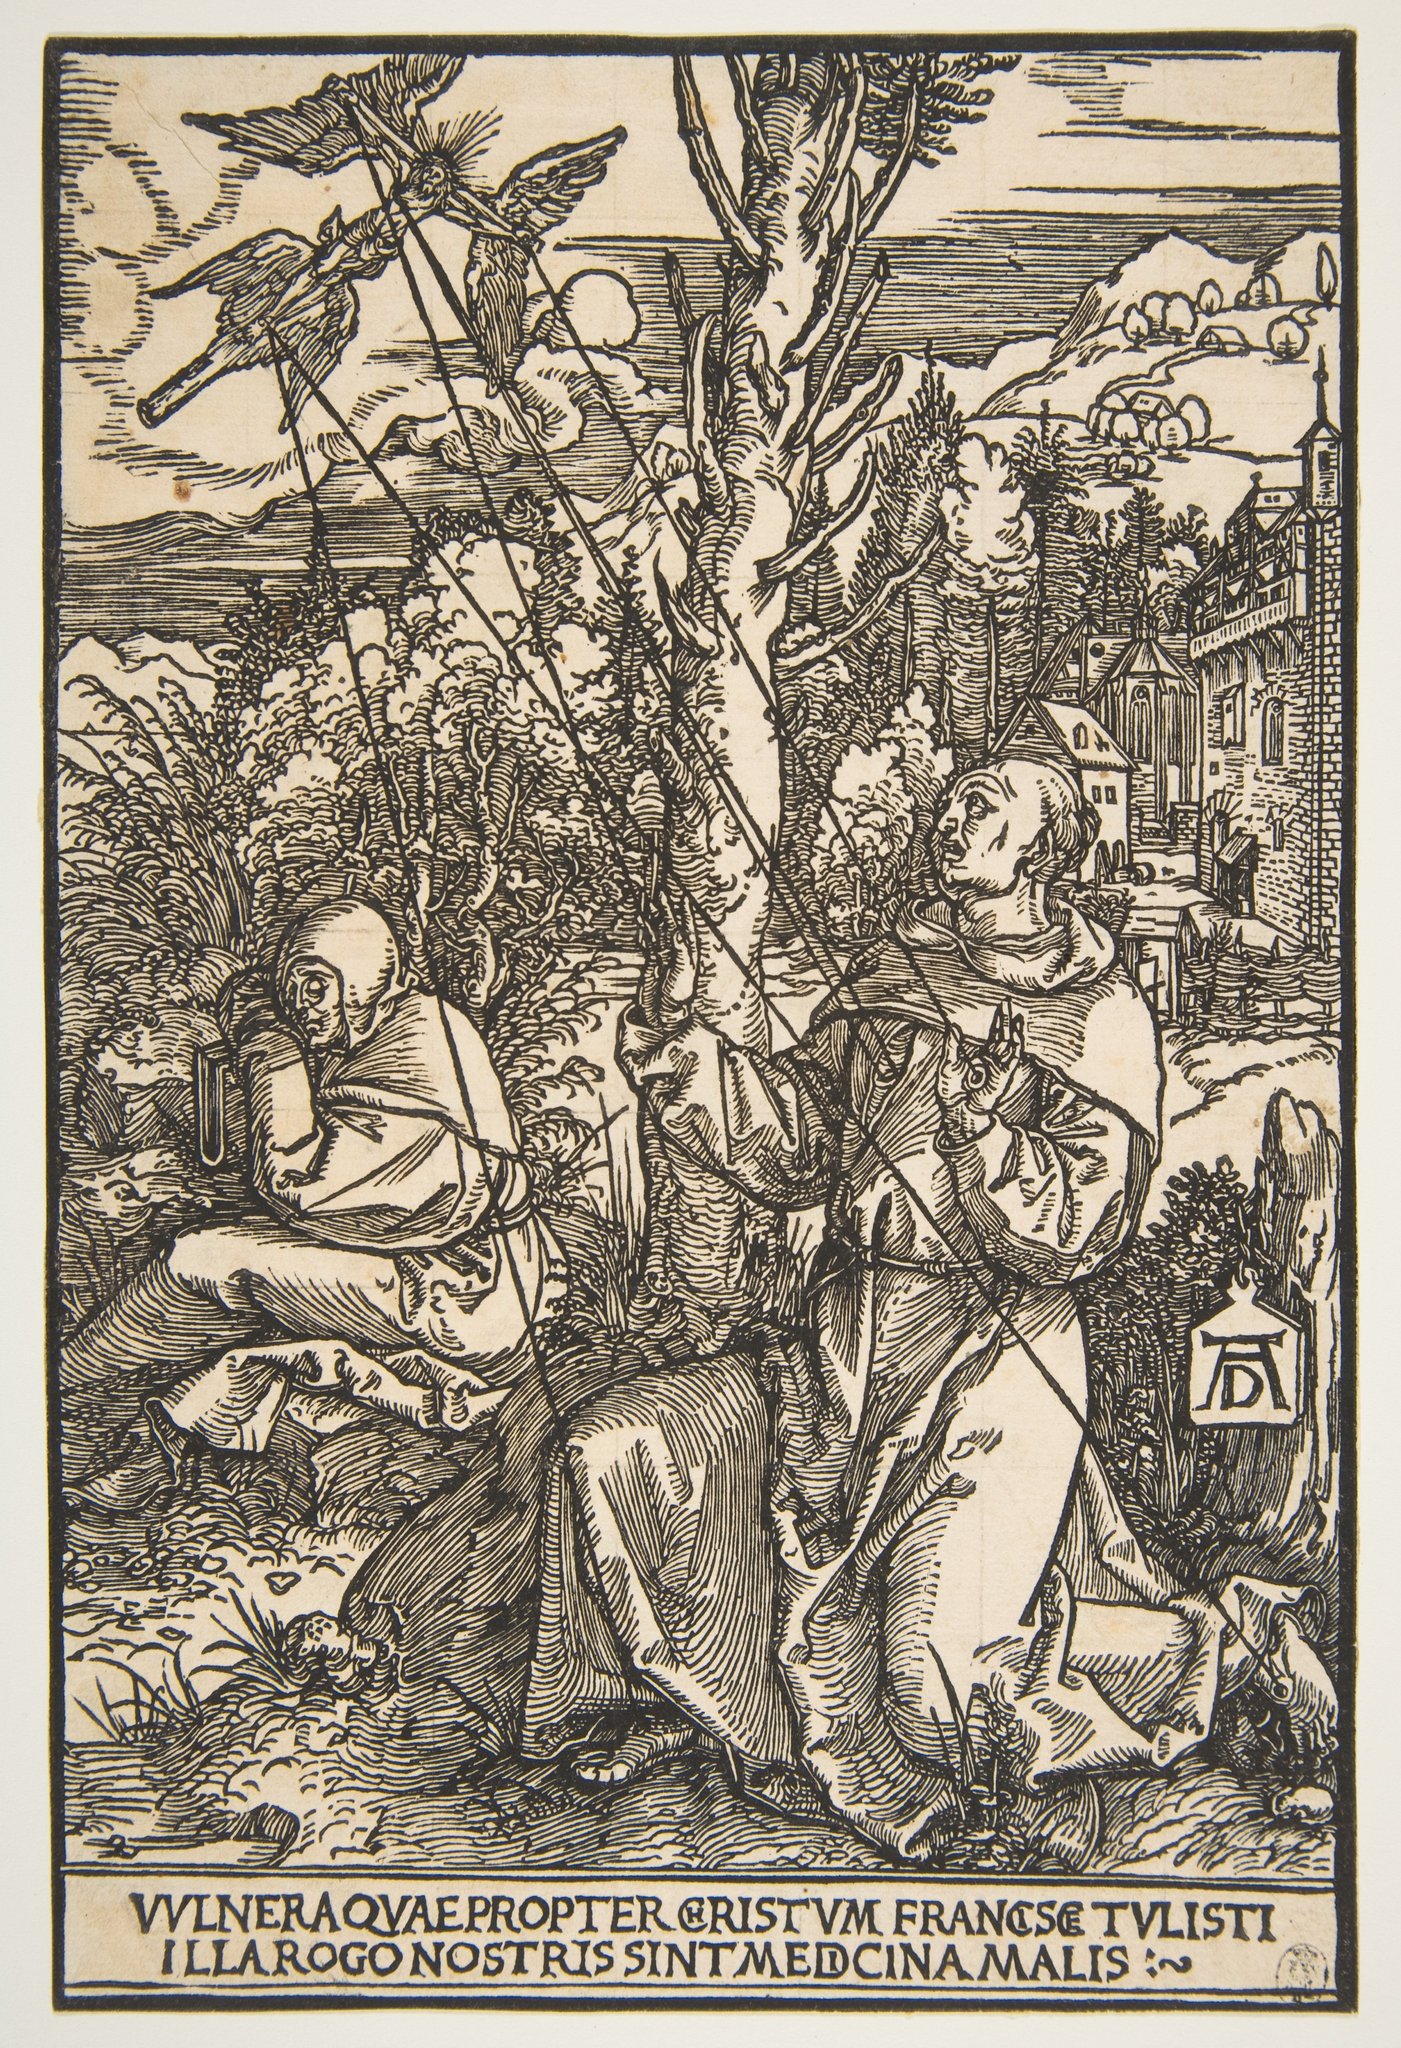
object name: print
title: Saint Francis Receiving the Stigmata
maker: albrecht dürer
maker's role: artist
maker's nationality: german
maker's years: 1471-1528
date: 1503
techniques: woodcut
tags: saint francis,crucifixion